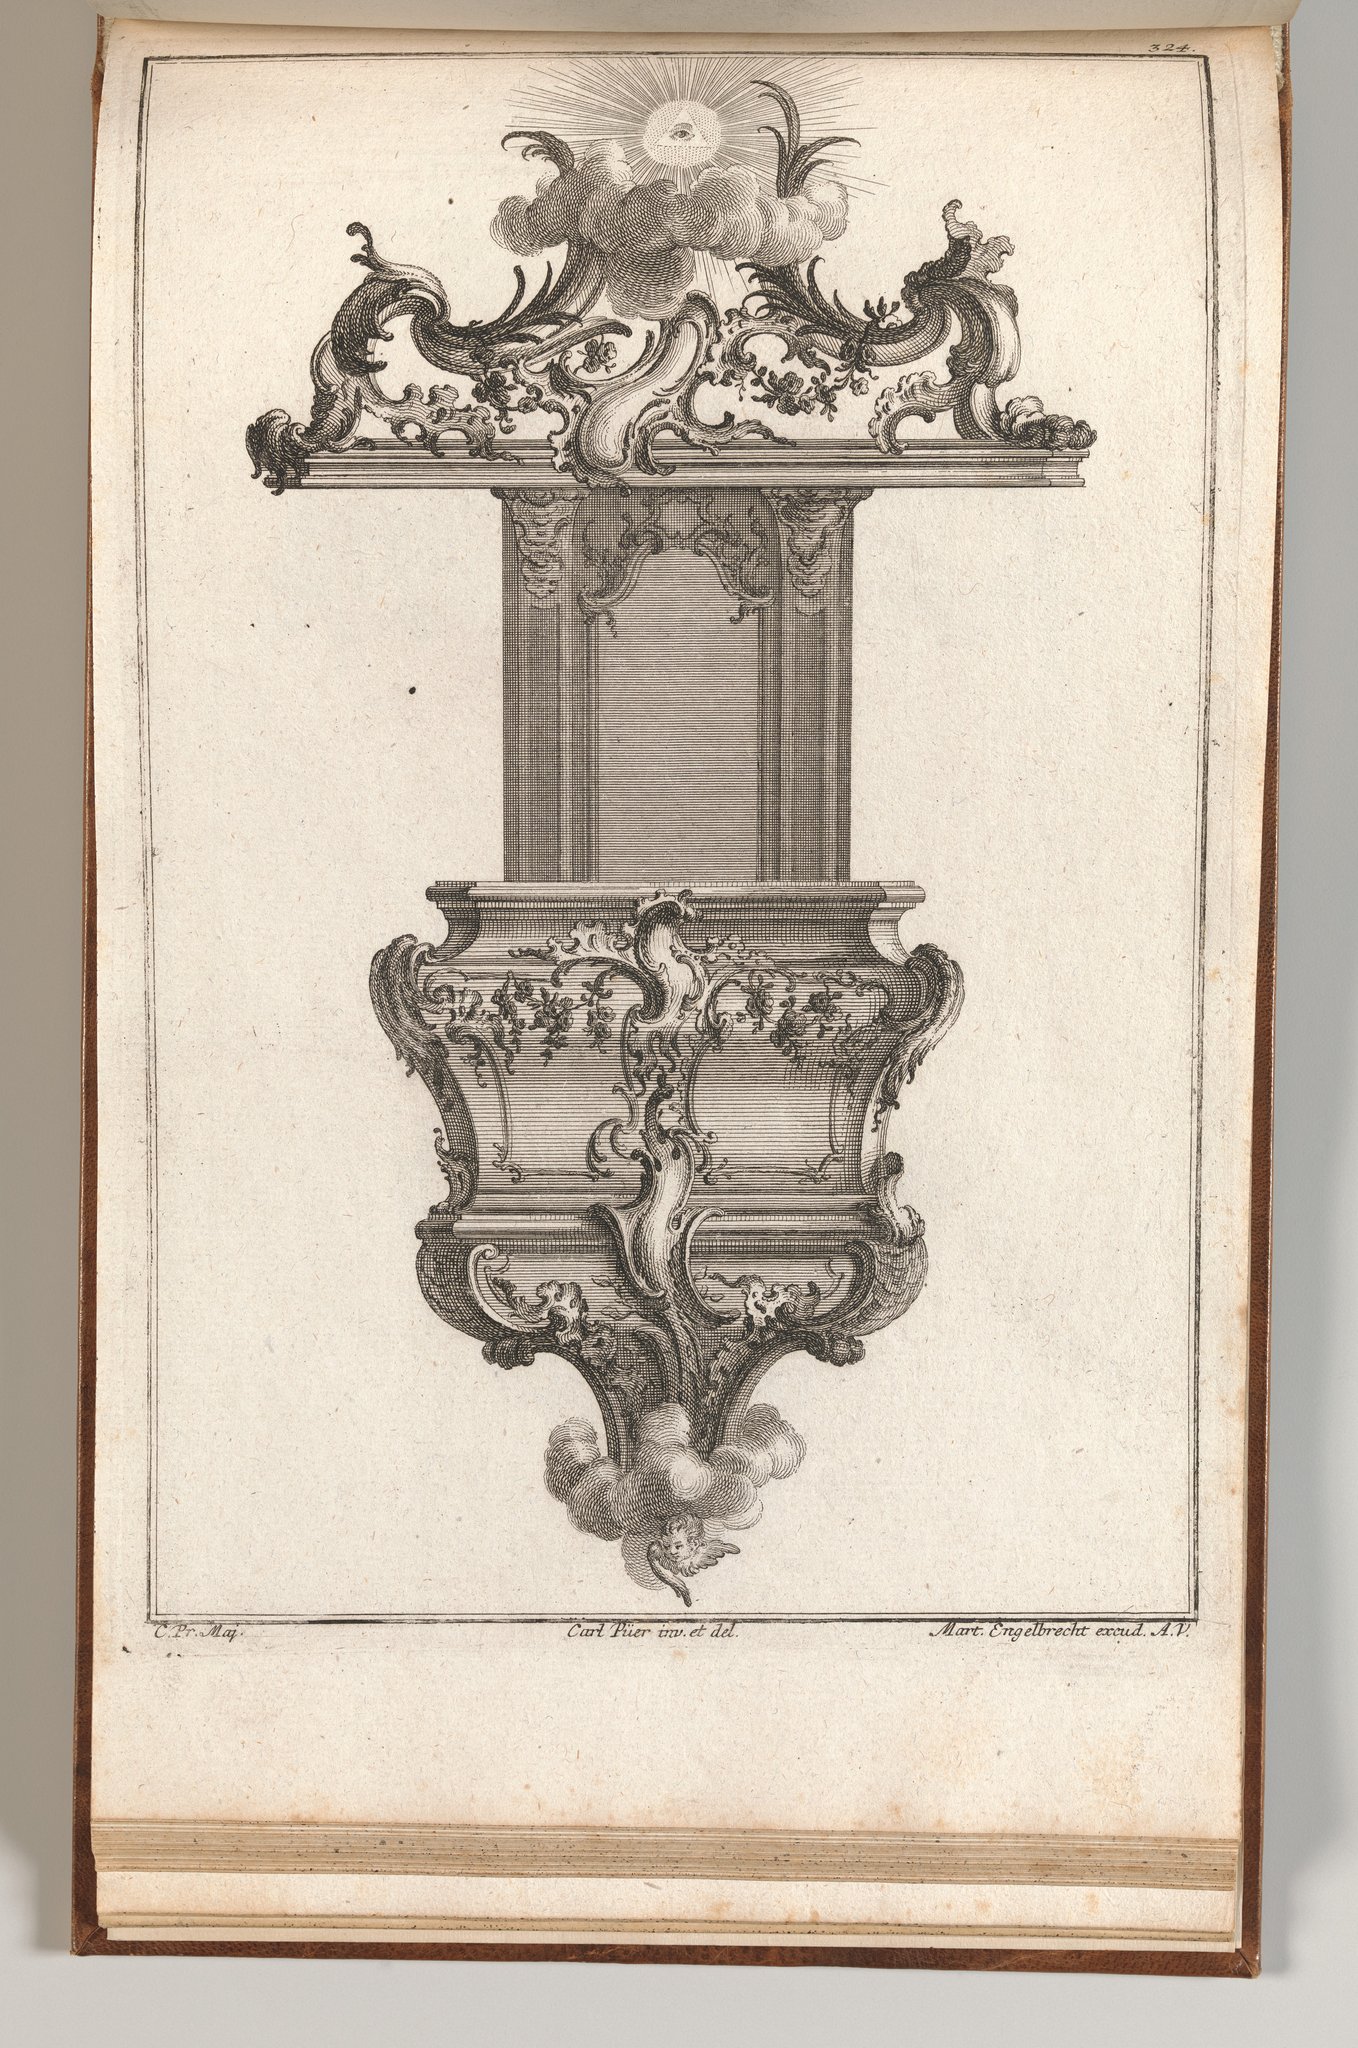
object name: album print ornament architecture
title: Design for a Pulpit, Plate 3 from an Untitled Series of Pulpit Designs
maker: carl pier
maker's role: artist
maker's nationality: german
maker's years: 1700-1790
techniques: etching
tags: architecture